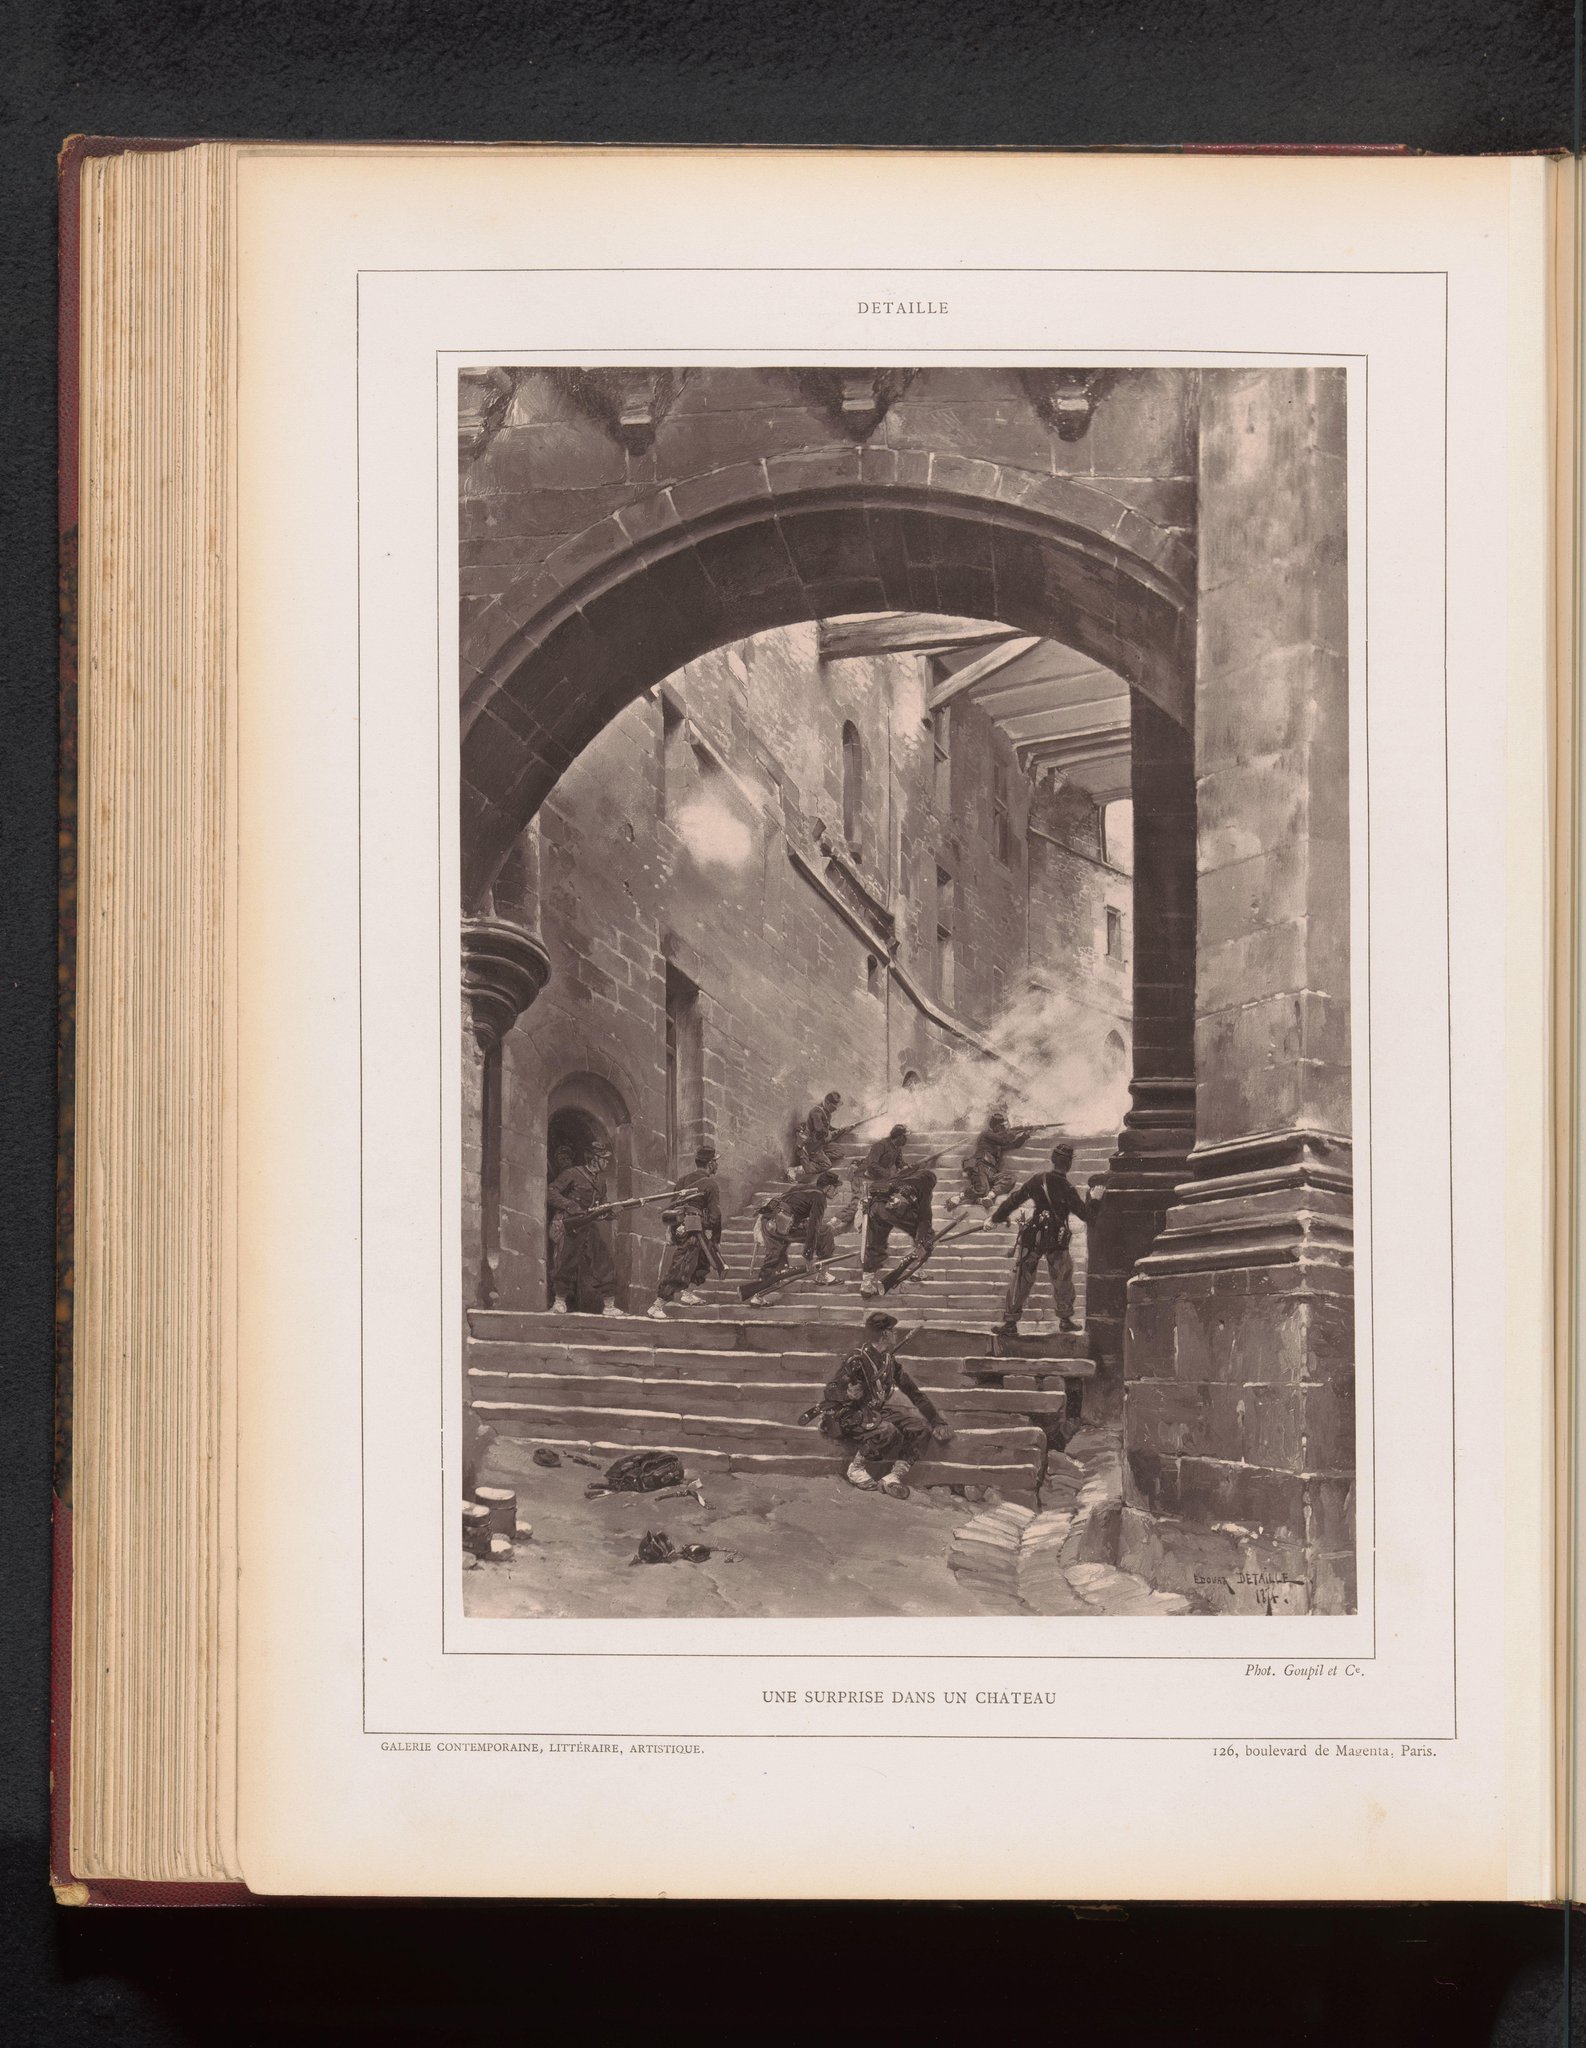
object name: reproduction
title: Reproductie van Une surprise dans un chateau door Édouard Detaille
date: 1871-1876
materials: paper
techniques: woodburytype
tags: the soldier; the soldier's life (+ during the battle), painting, drawing and the graphic arts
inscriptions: inscription: ‘Detaille/ Galerie Contemporaine, Littéraire et Artistique/ 126, boulevard de Magenta, Paris.’